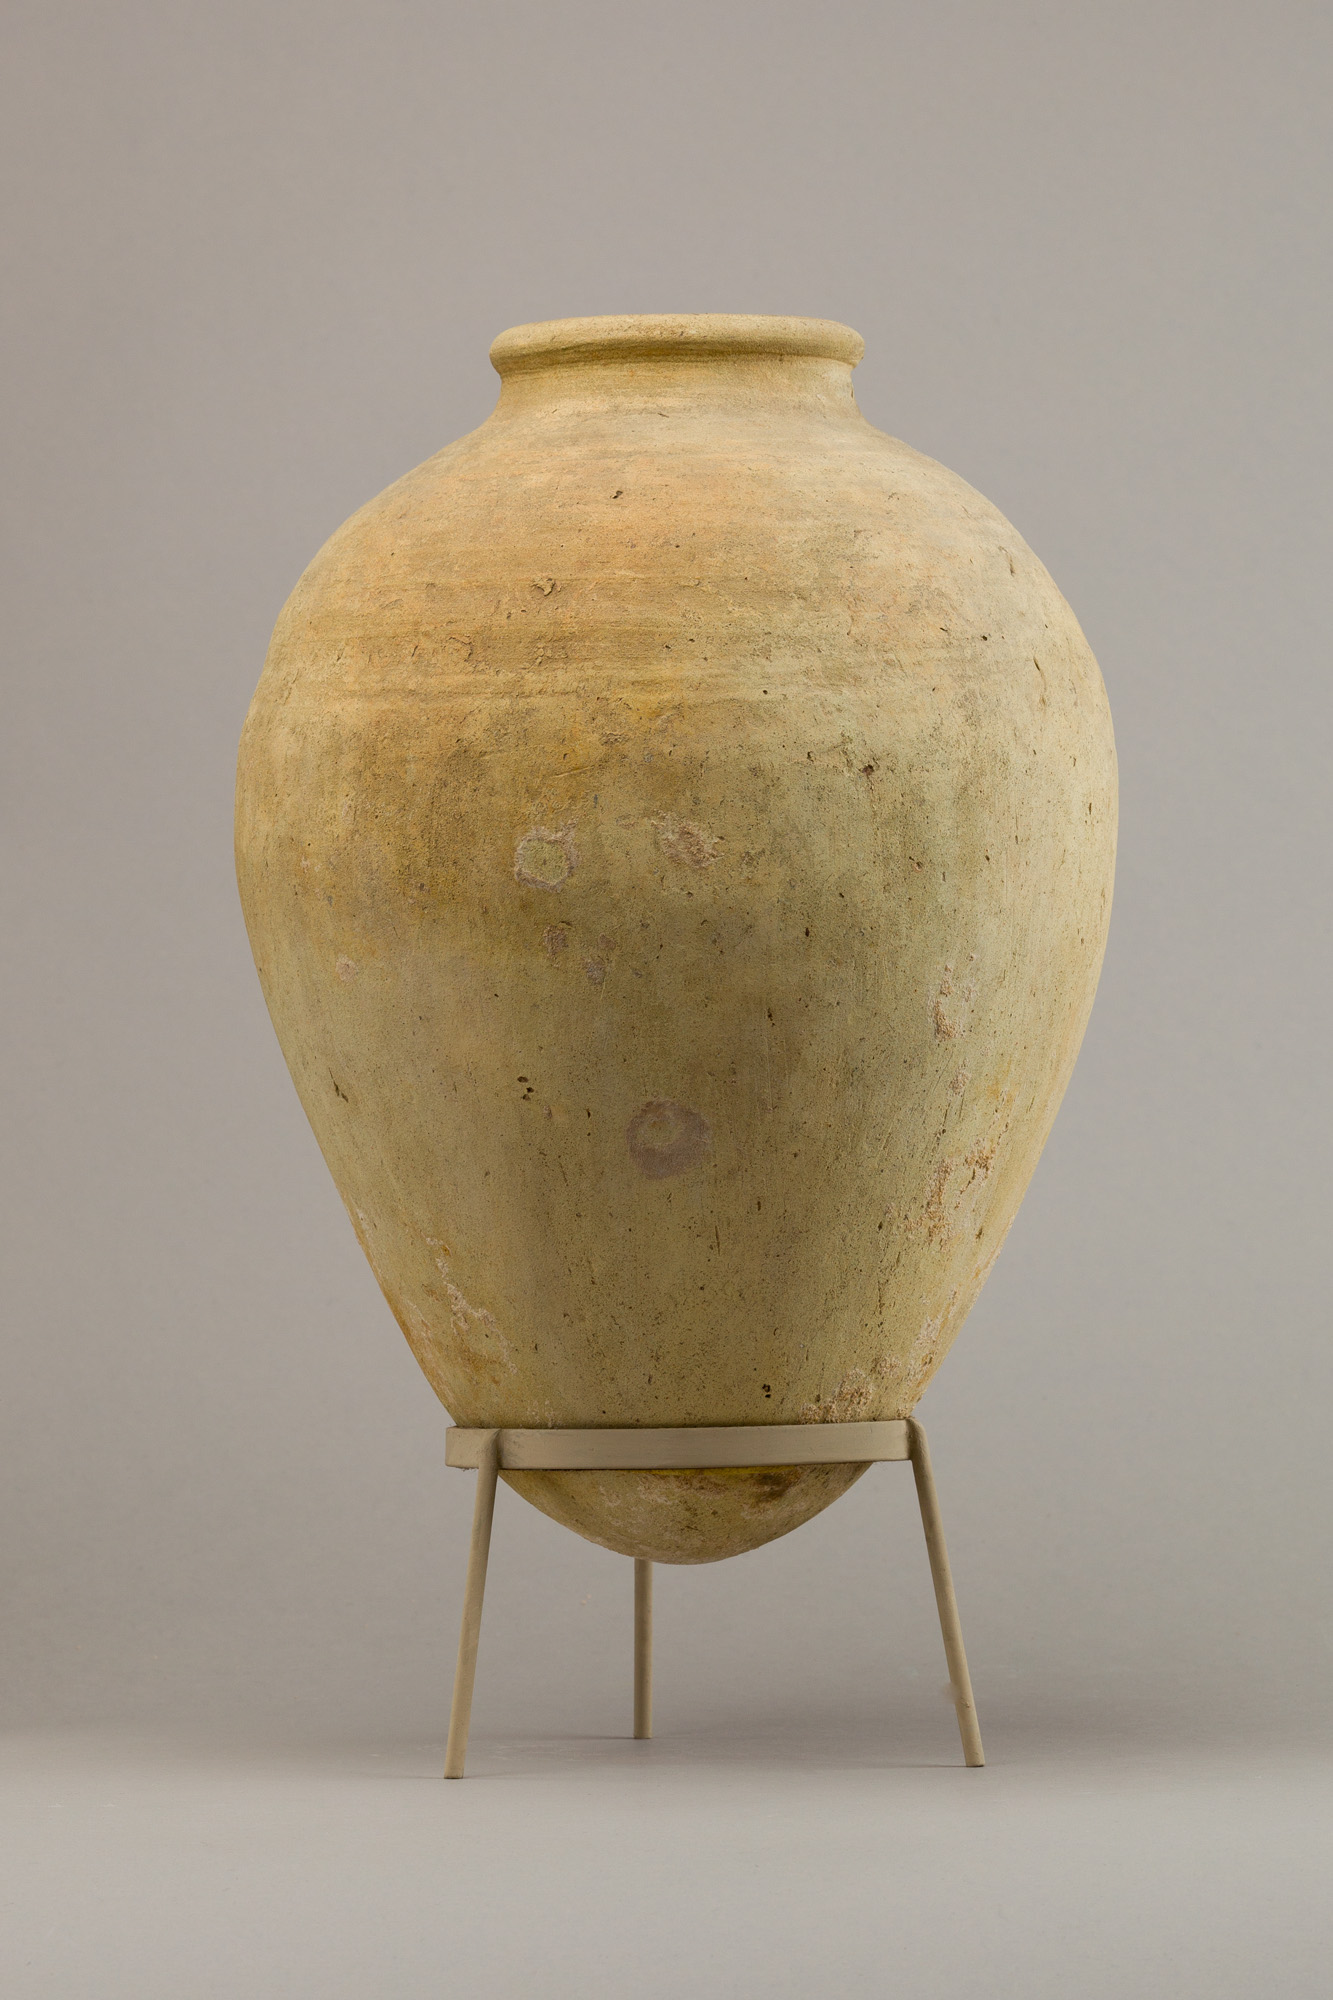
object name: jar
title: Large jar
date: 2649-2100 BCE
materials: pottery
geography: egypt